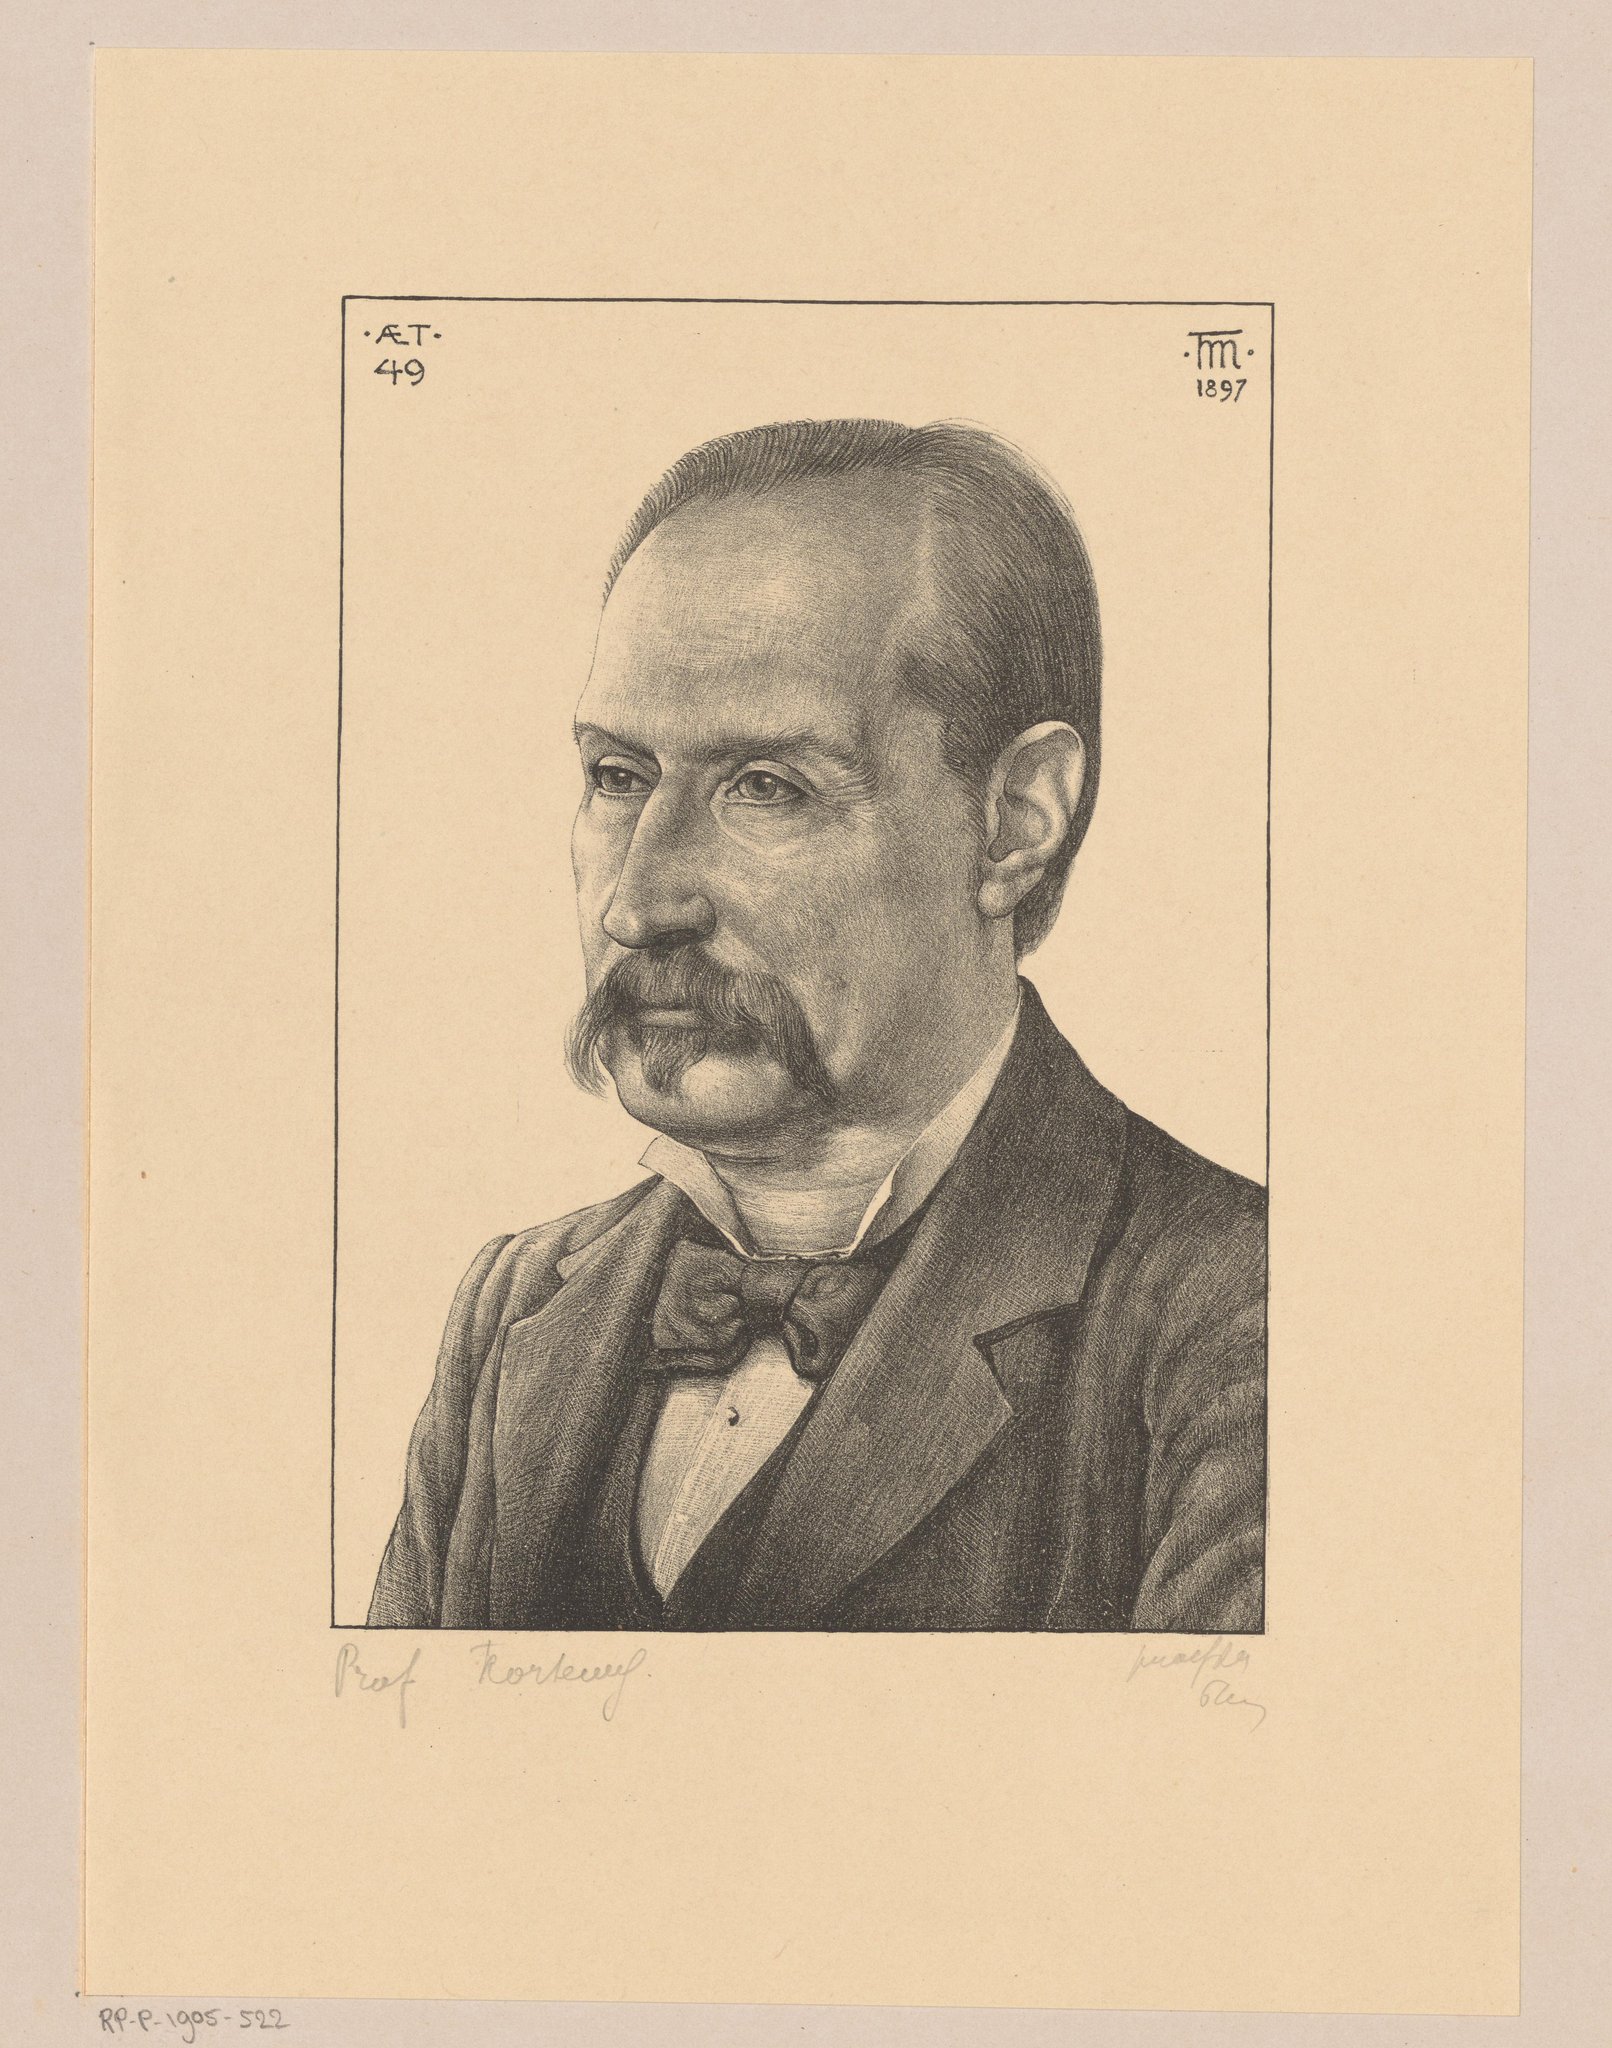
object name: print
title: Portret van Diederik Johannes Korteweg op 49-jarige leeftijd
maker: theo molkenboer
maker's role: draughtsman, print maker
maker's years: 1871-1920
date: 1897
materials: paper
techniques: lithograph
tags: den bosch, historical persons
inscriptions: collector's mark: Lugt 2228